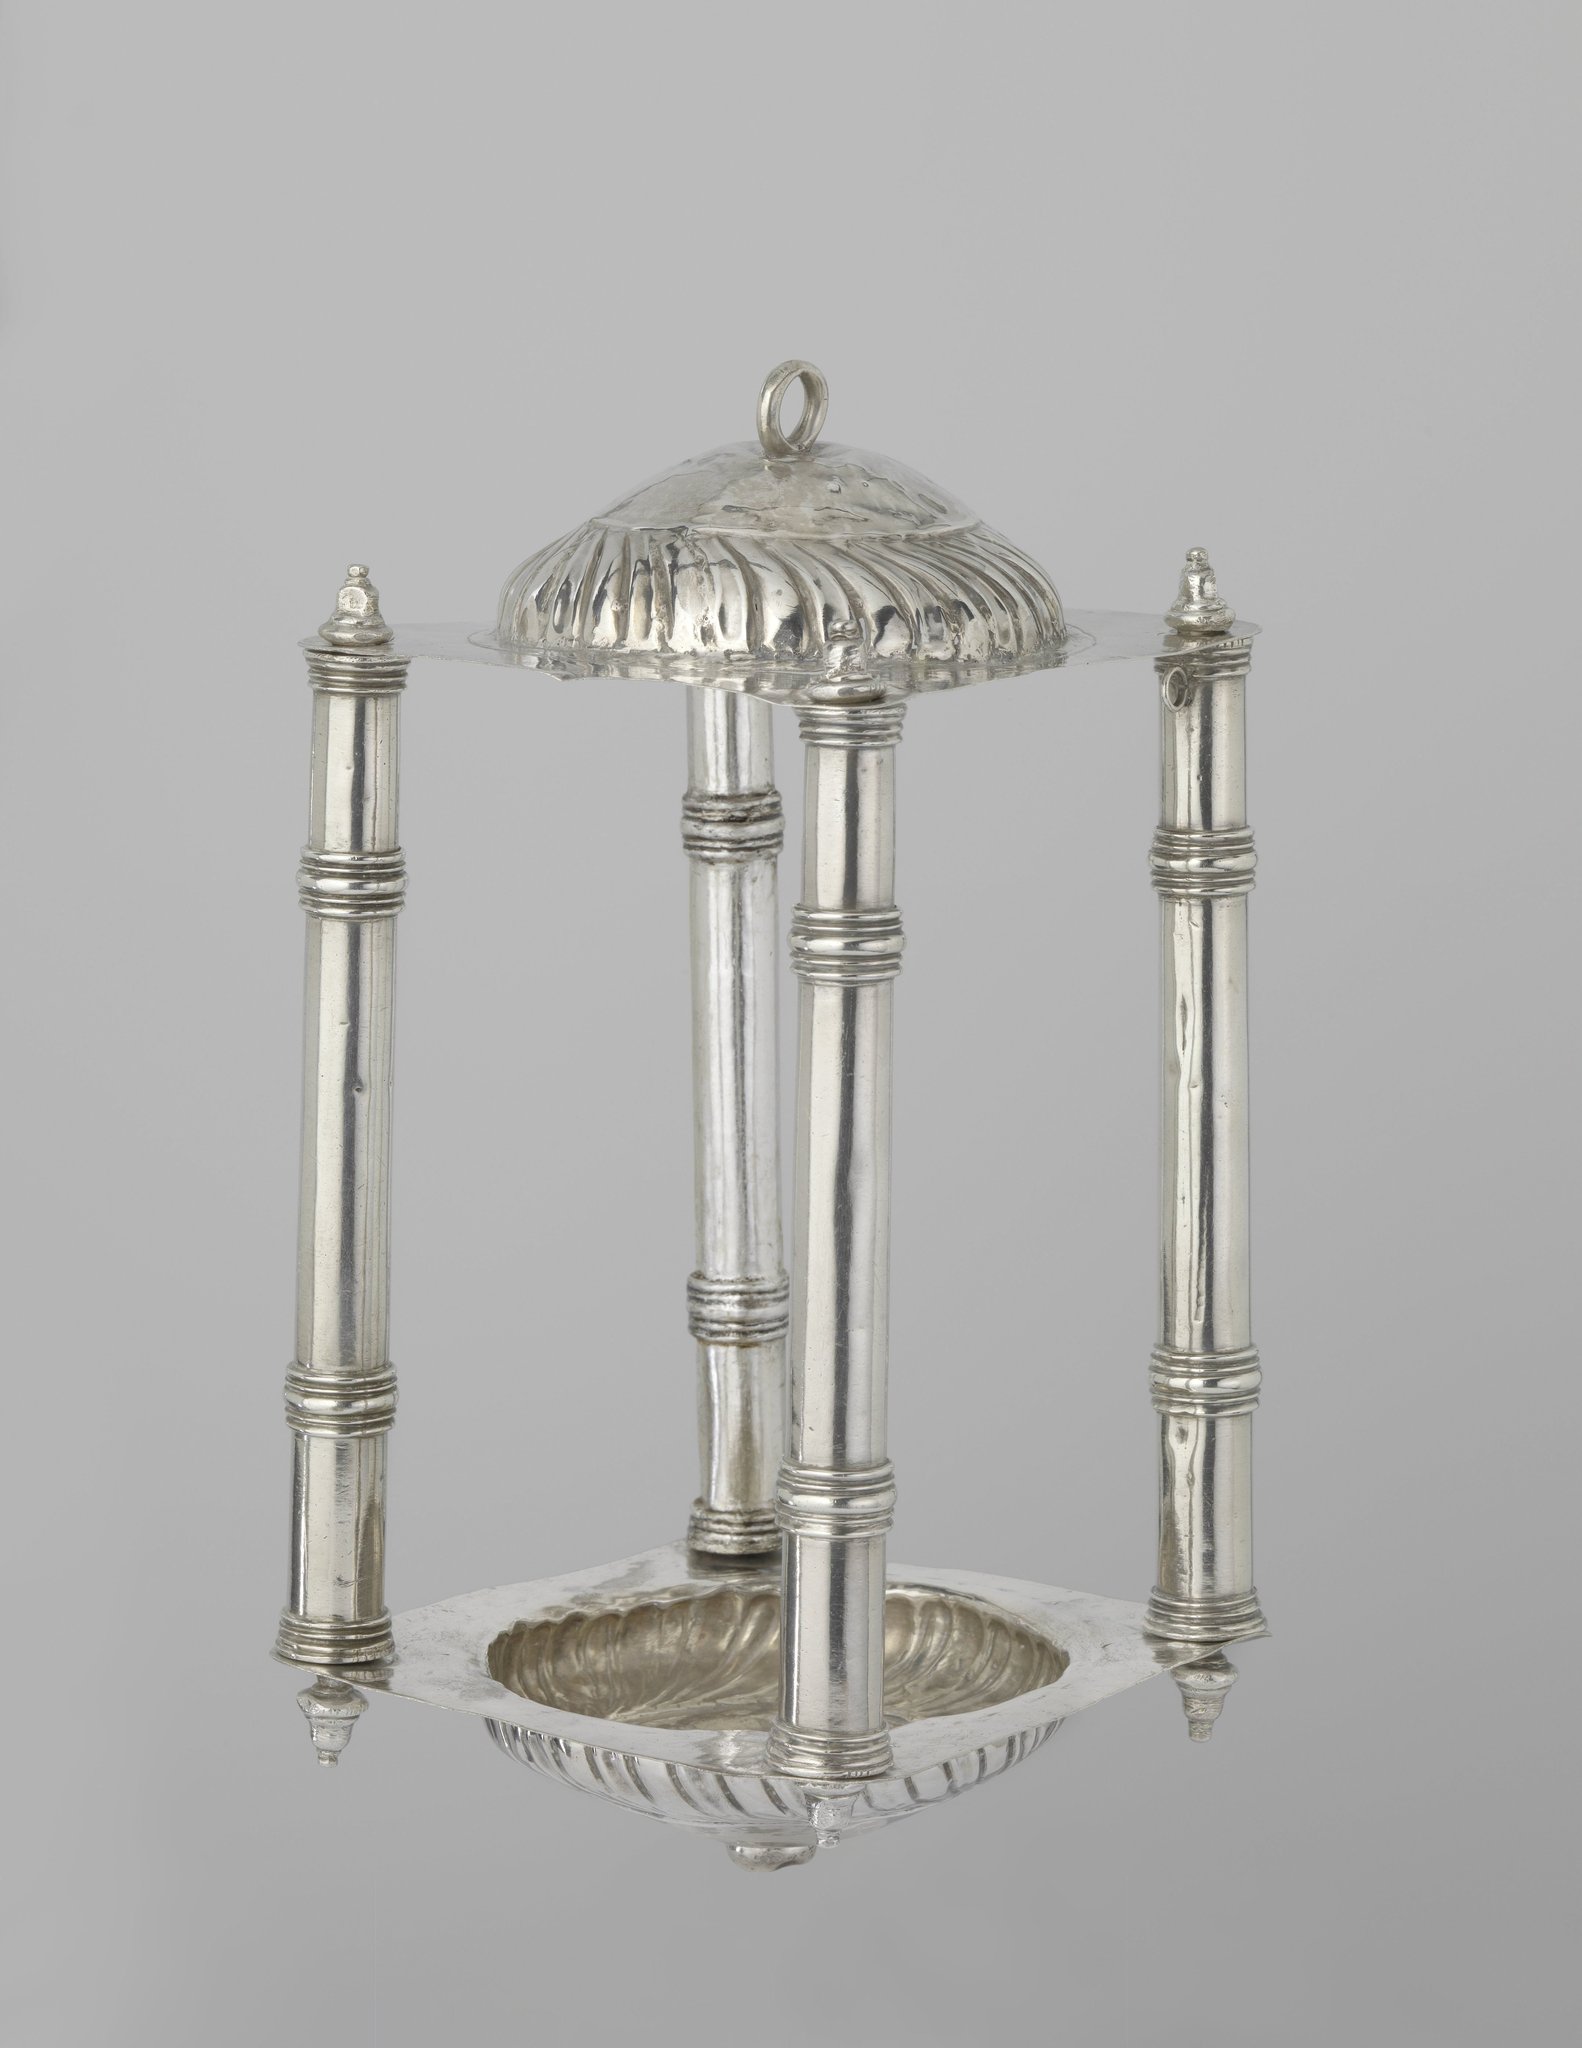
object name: lantern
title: Zilveren lantaarn, mogelijk afkomstig uit een synagoge in Suriname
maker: Anonymous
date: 1720-1740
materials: silver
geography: netherlands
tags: suriname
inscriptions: mark: ‘[...]’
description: Zilveren lantaarn of lamp gevormd door vier kolommen of pilaren (één manco) die aan de bovenzijde een zilveren dak dragen en aan de onderzijde een vergelijkbaar bakje voor de lampenolie. Waarschijnlijk zat de olie in een tinnen binnen-bakje ter bescherming van het zilveren bakje. De kolommen hebben aan beide uiteinden kleine peervormige knopjes met een schroefdraad. Hierdoor is het mogelijk de lamp in en uit elkaar te zetten. Bovenaan de kolommen, net onder het dak, bevinden zich oogjes voor de bevestiging van een windglas dat moest voorkomen dat de vlam zou doven. Aan het oog op het dak van de lantaarn kon de lamp worden opgehangen. Voor de vierde ontbrekende kolom is een replica gemaakt op basis van de drie overgebleven kolommen. Dergelijke lampen werden in kerken en synagogen gebruikt als verlichting. Er zijn ook exemplaren bekend die werden gebruikt voor het branden van het eeuwige licht in de synagoge. Deze lampen hebben vaak een inscriptie ter nagedachtenis aan een persoon. Het uiterlijk van de lamp wijst op vervaardiging in Nederland. Het is niet duidelijk wanneer de lamp naar Suriname is gebracht en in welke context deze daar heeft gefunctioneerd. Mogelijk is het een geschenk geweest van geloofsgenoten in Nederland aan de joodse gemeenschap in Suriname.